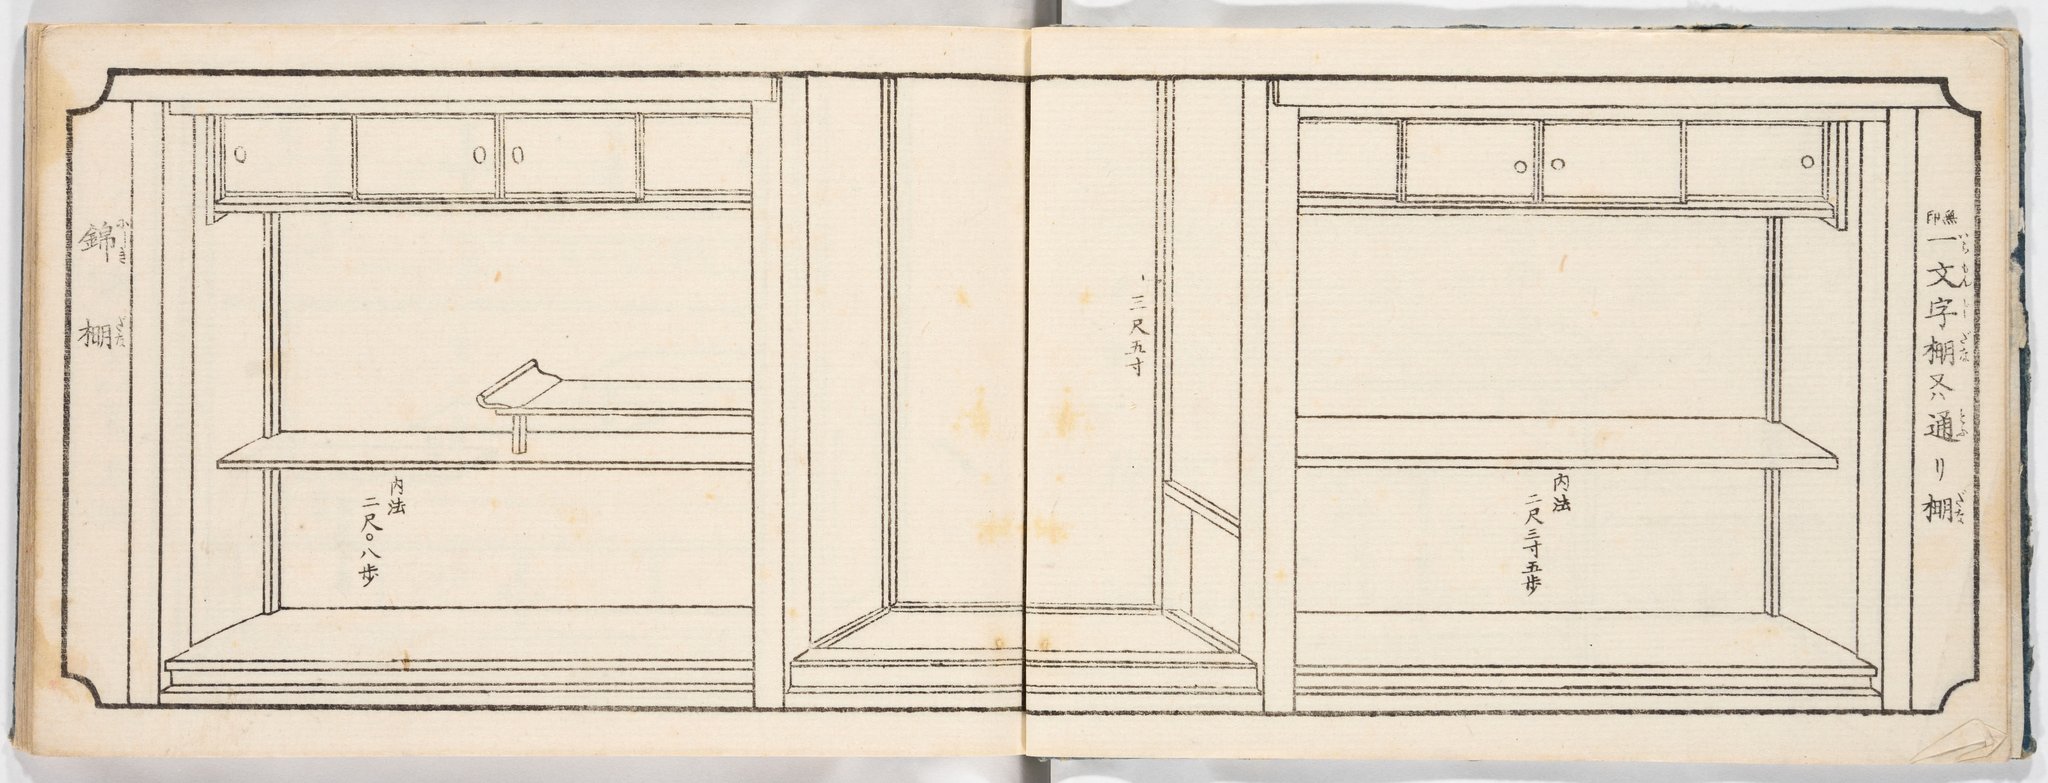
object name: illustrated book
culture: japanese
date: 1893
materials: ink, paper